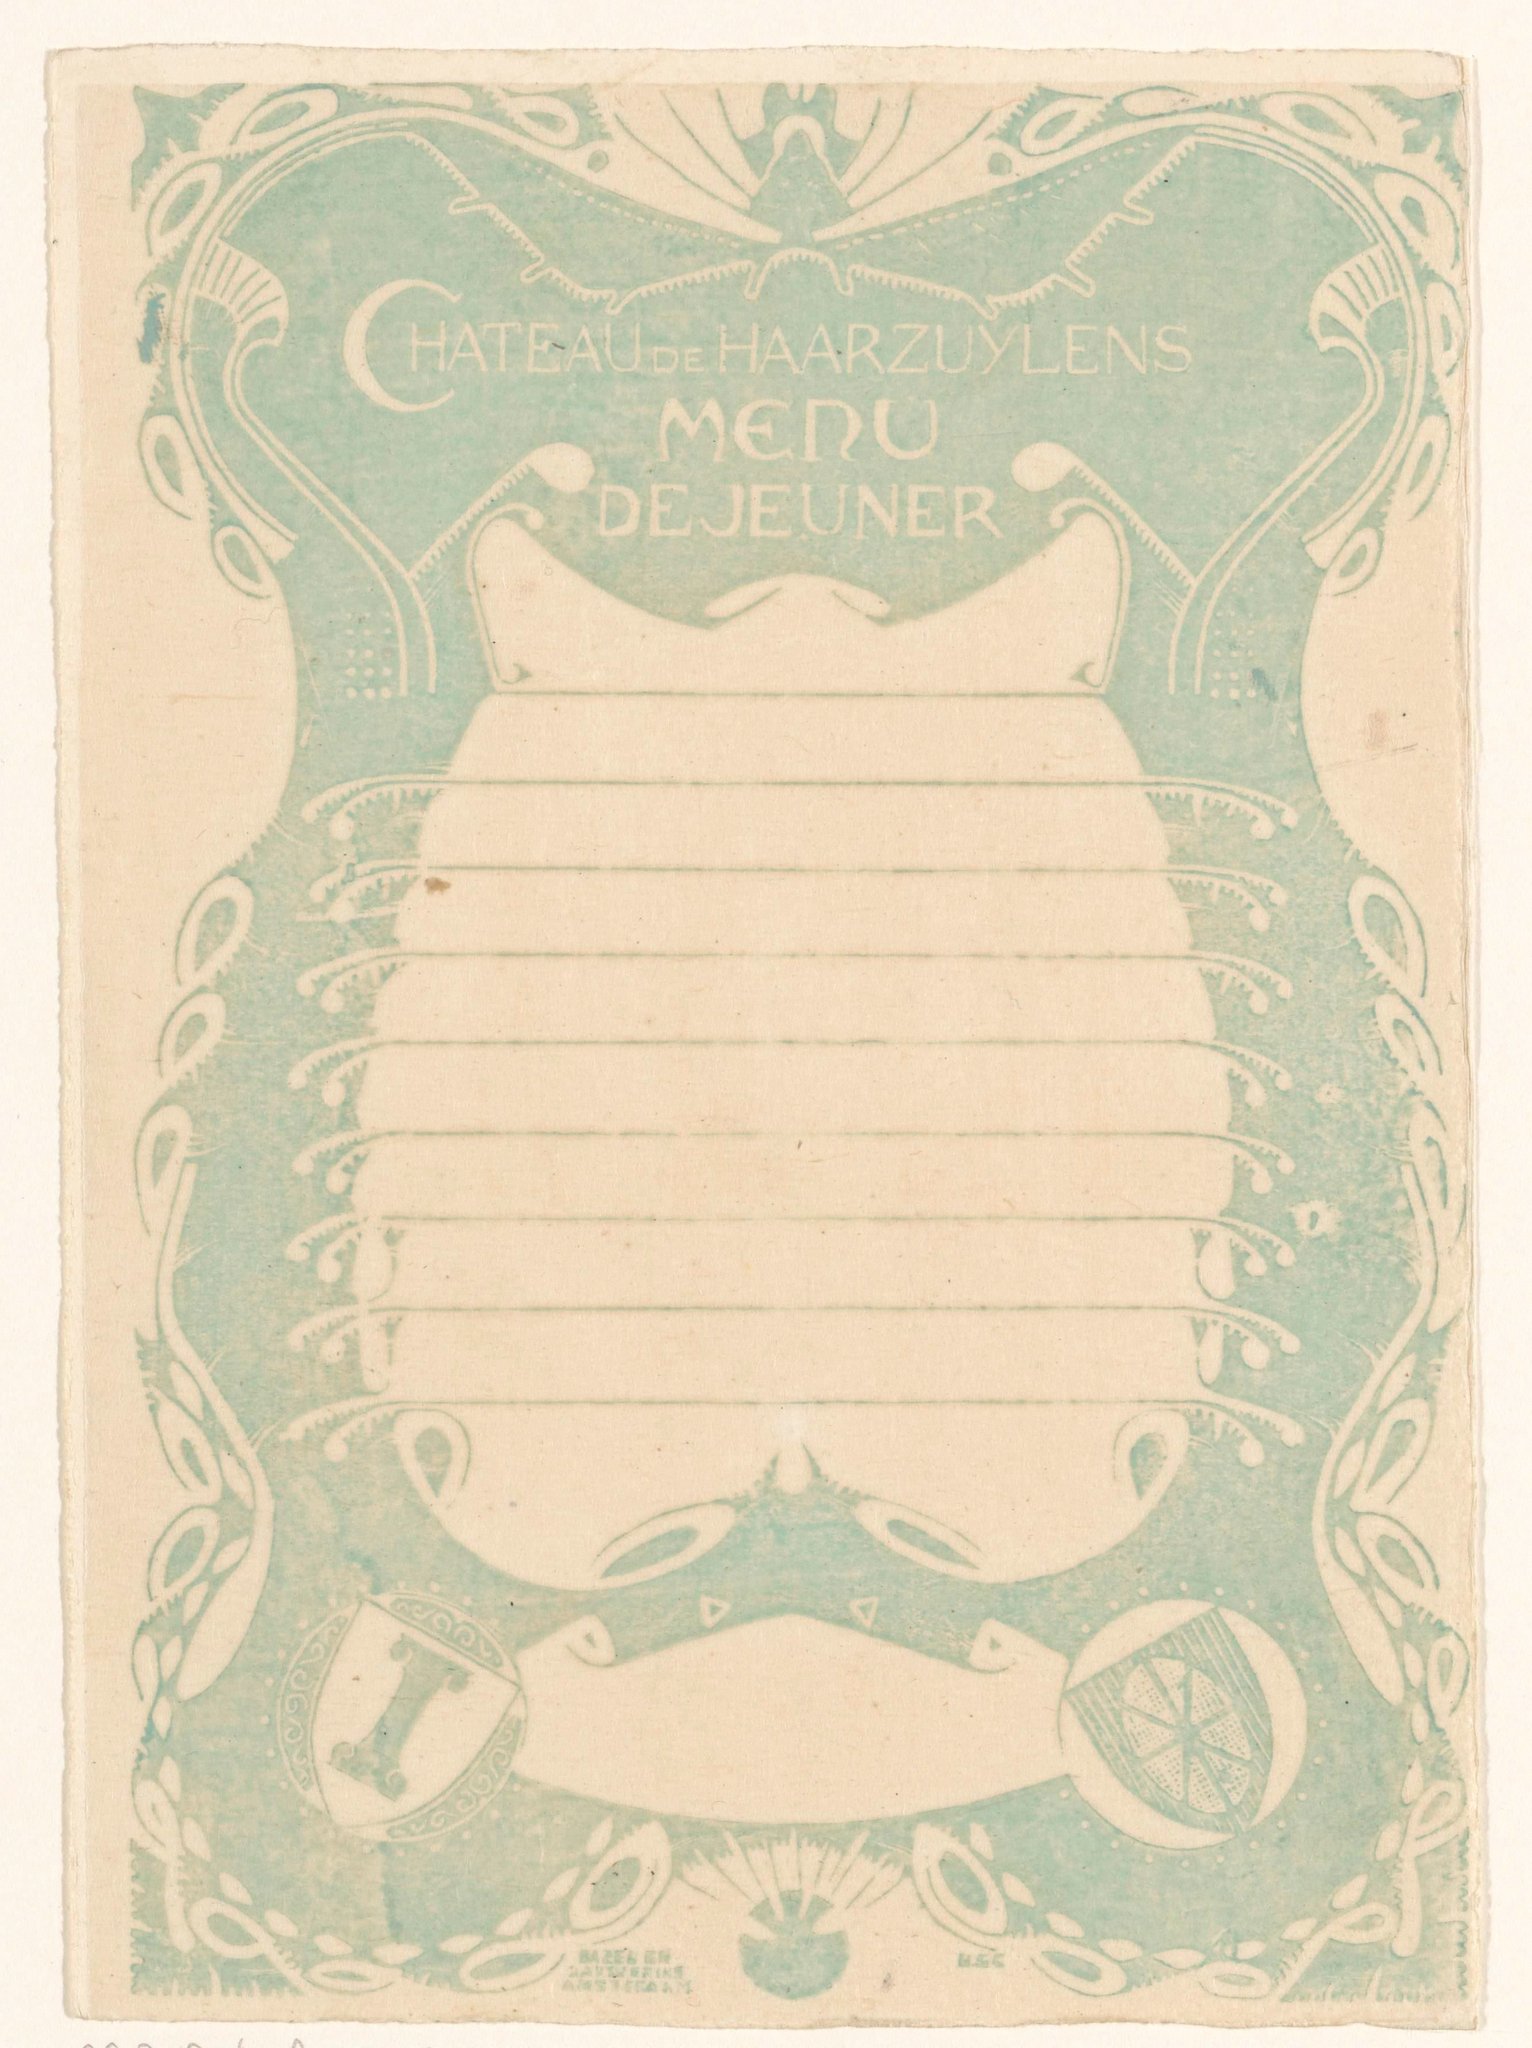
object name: menu, menukaart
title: Menukaart Château de Haarzuijlens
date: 1896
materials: paper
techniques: woodcut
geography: amsterdam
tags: kasteel de haar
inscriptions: collector's mark: Lugt 2228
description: Menukaart voor Kasteel de Haar bij Haarzuilens.